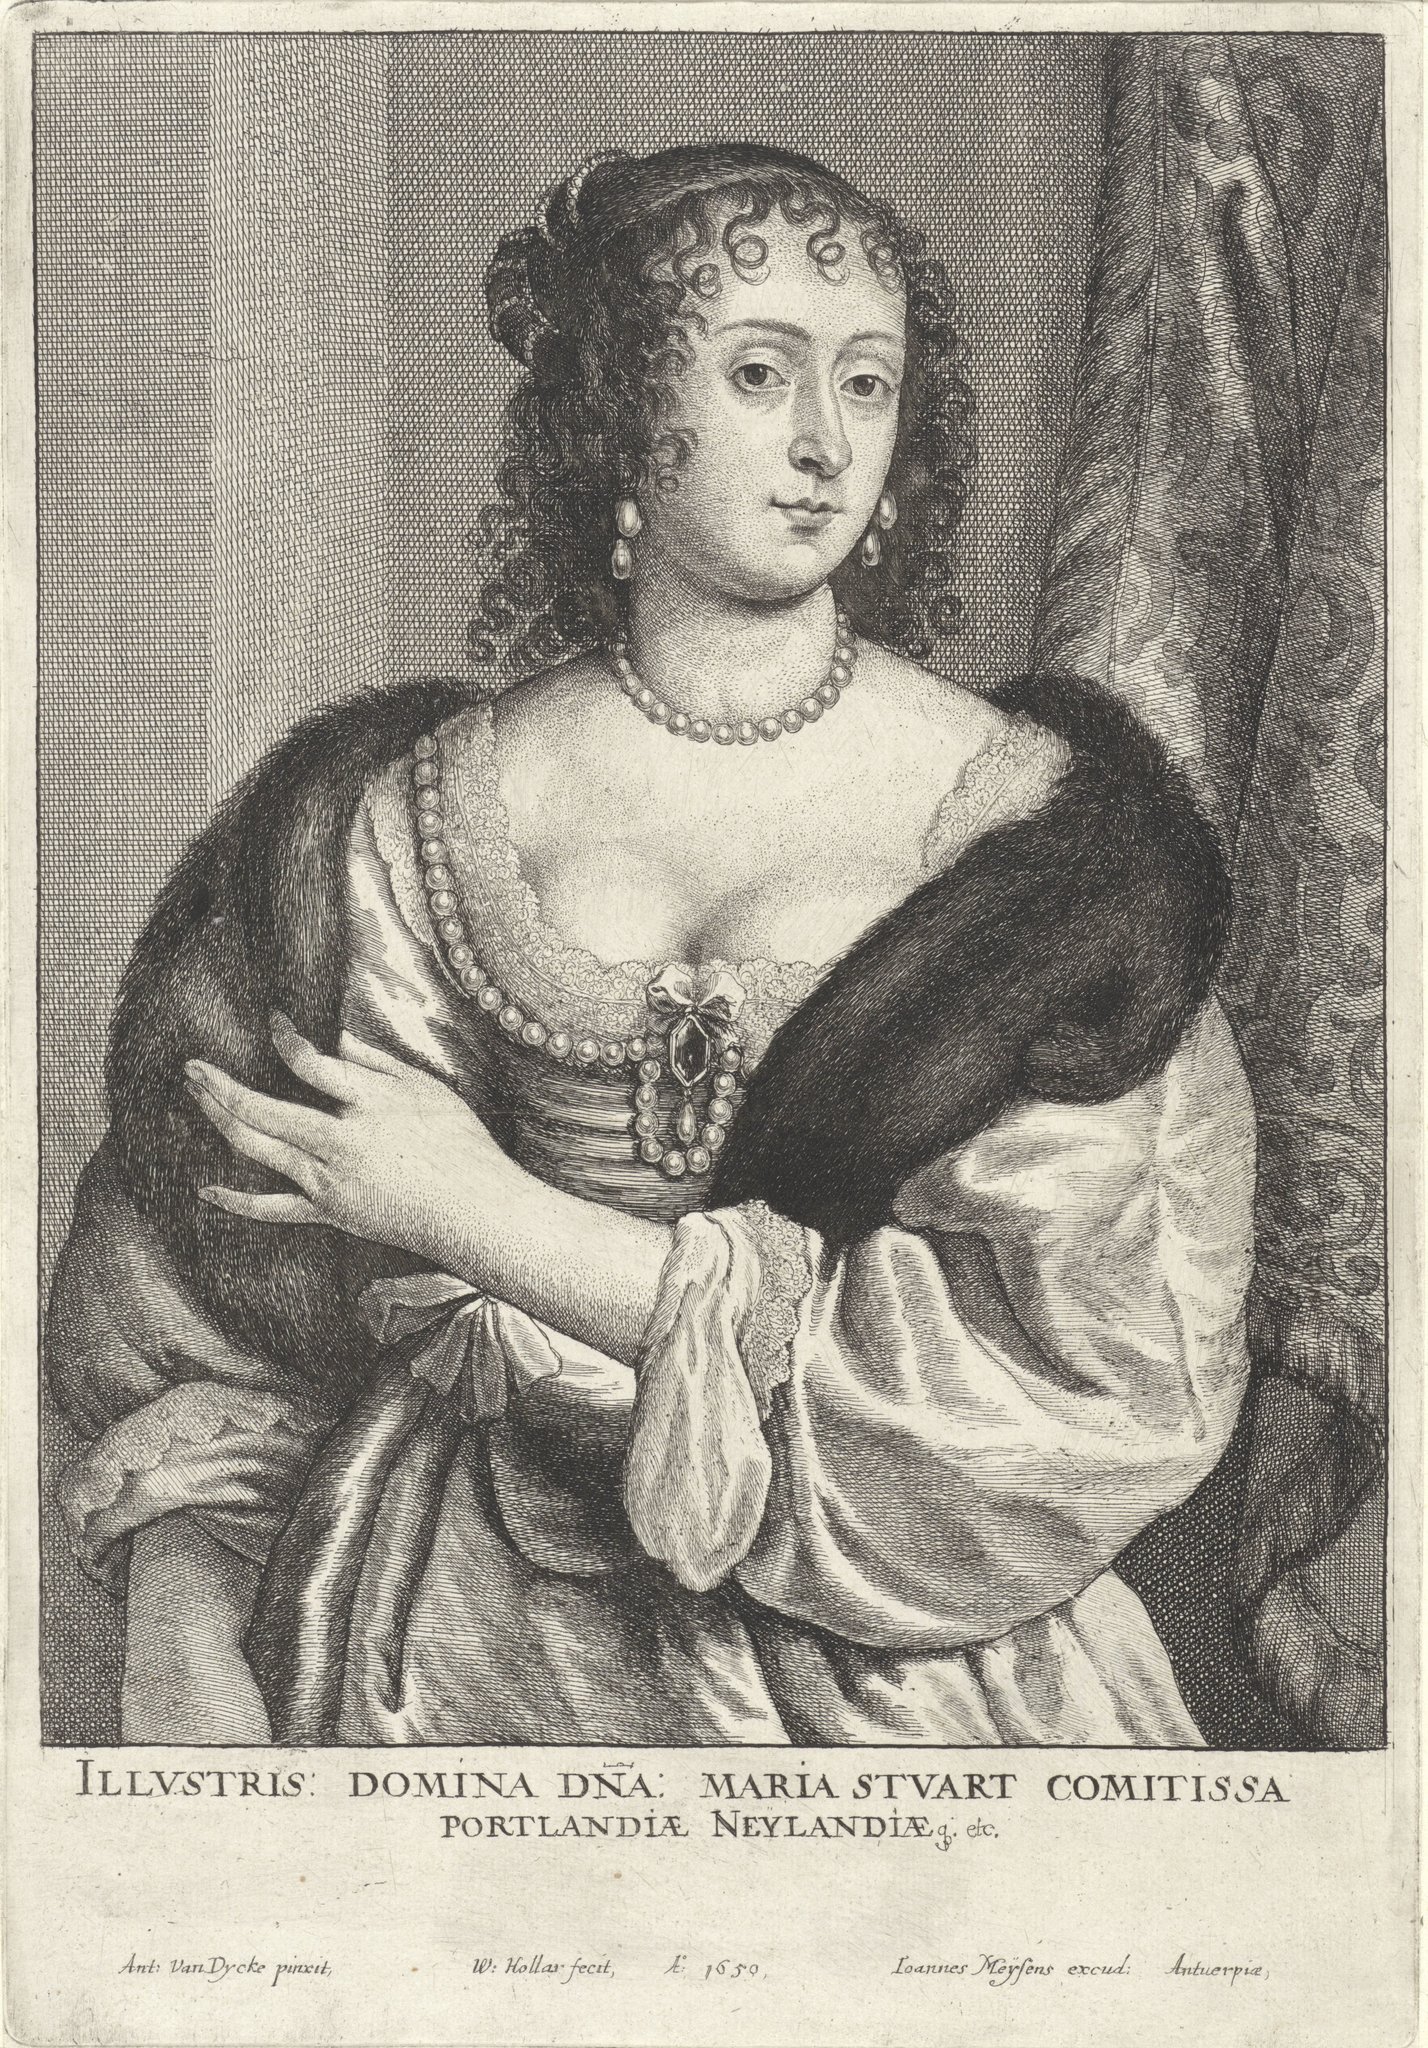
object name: print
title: Portretten naar Anthony van Dyck door Joannes Meyssens uitgegeven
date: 1650-1670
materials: paper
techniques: etching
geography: antwerp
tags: frances stuart (gravin van portland)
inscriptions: collector's mark: Lugt 240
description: De prent maakt deel uit van een zevendelige serie portretten naar Anthony van Dyck, uitgegeven door Joannes Meyssens.